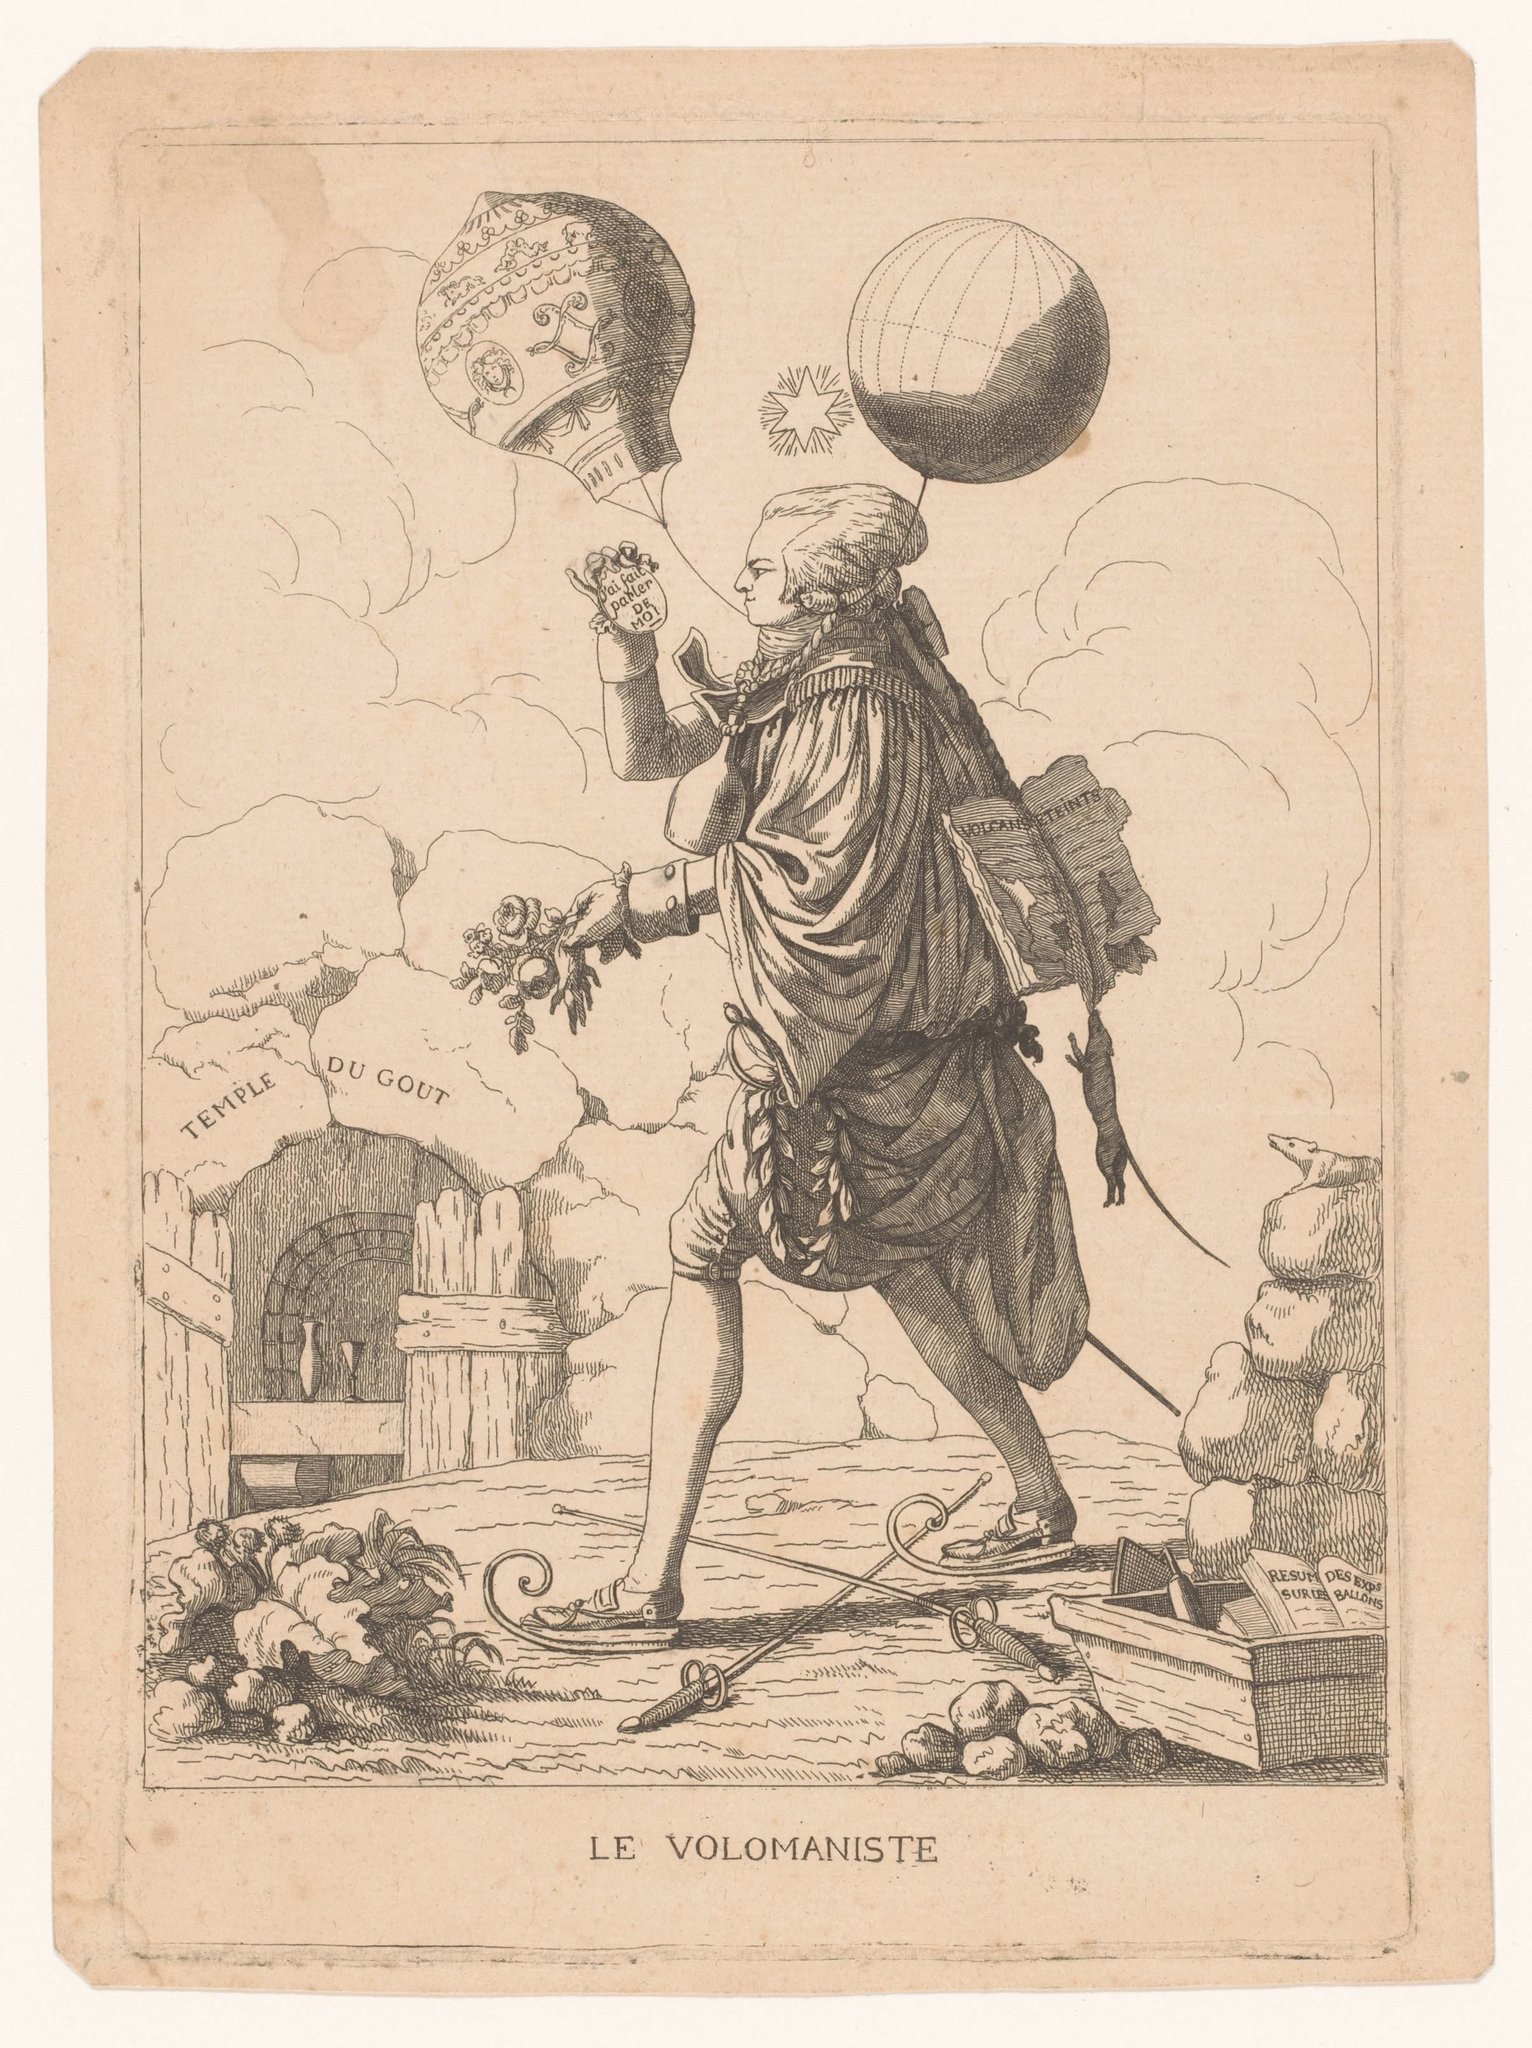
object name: print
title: Satire op een ballonvaarder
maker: Anonymous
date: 1784-1785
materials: paper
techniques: etching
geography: france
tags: balloon (aviation) (+ variant), historical persons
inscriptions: collector's mark: Lugt 2228, collector's mark: Lugt 2760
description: Satire op de ballonvaarder, mogelijk op Barthélemy Faujas de Saint-Fond die in 1783-84 publiceerde over de vluchten van de gebroeders Montgolfier. Man loopt op schaatsen over het land richting poort 'temple du gout'. Aan zijn hoofd twee luchtballonnen. Op zijn rug hangt een door een rat aangevreten exemplaar van zijn boek 'Recherches sur les volcans éteints du Vivarais et du Velay' van 1778.